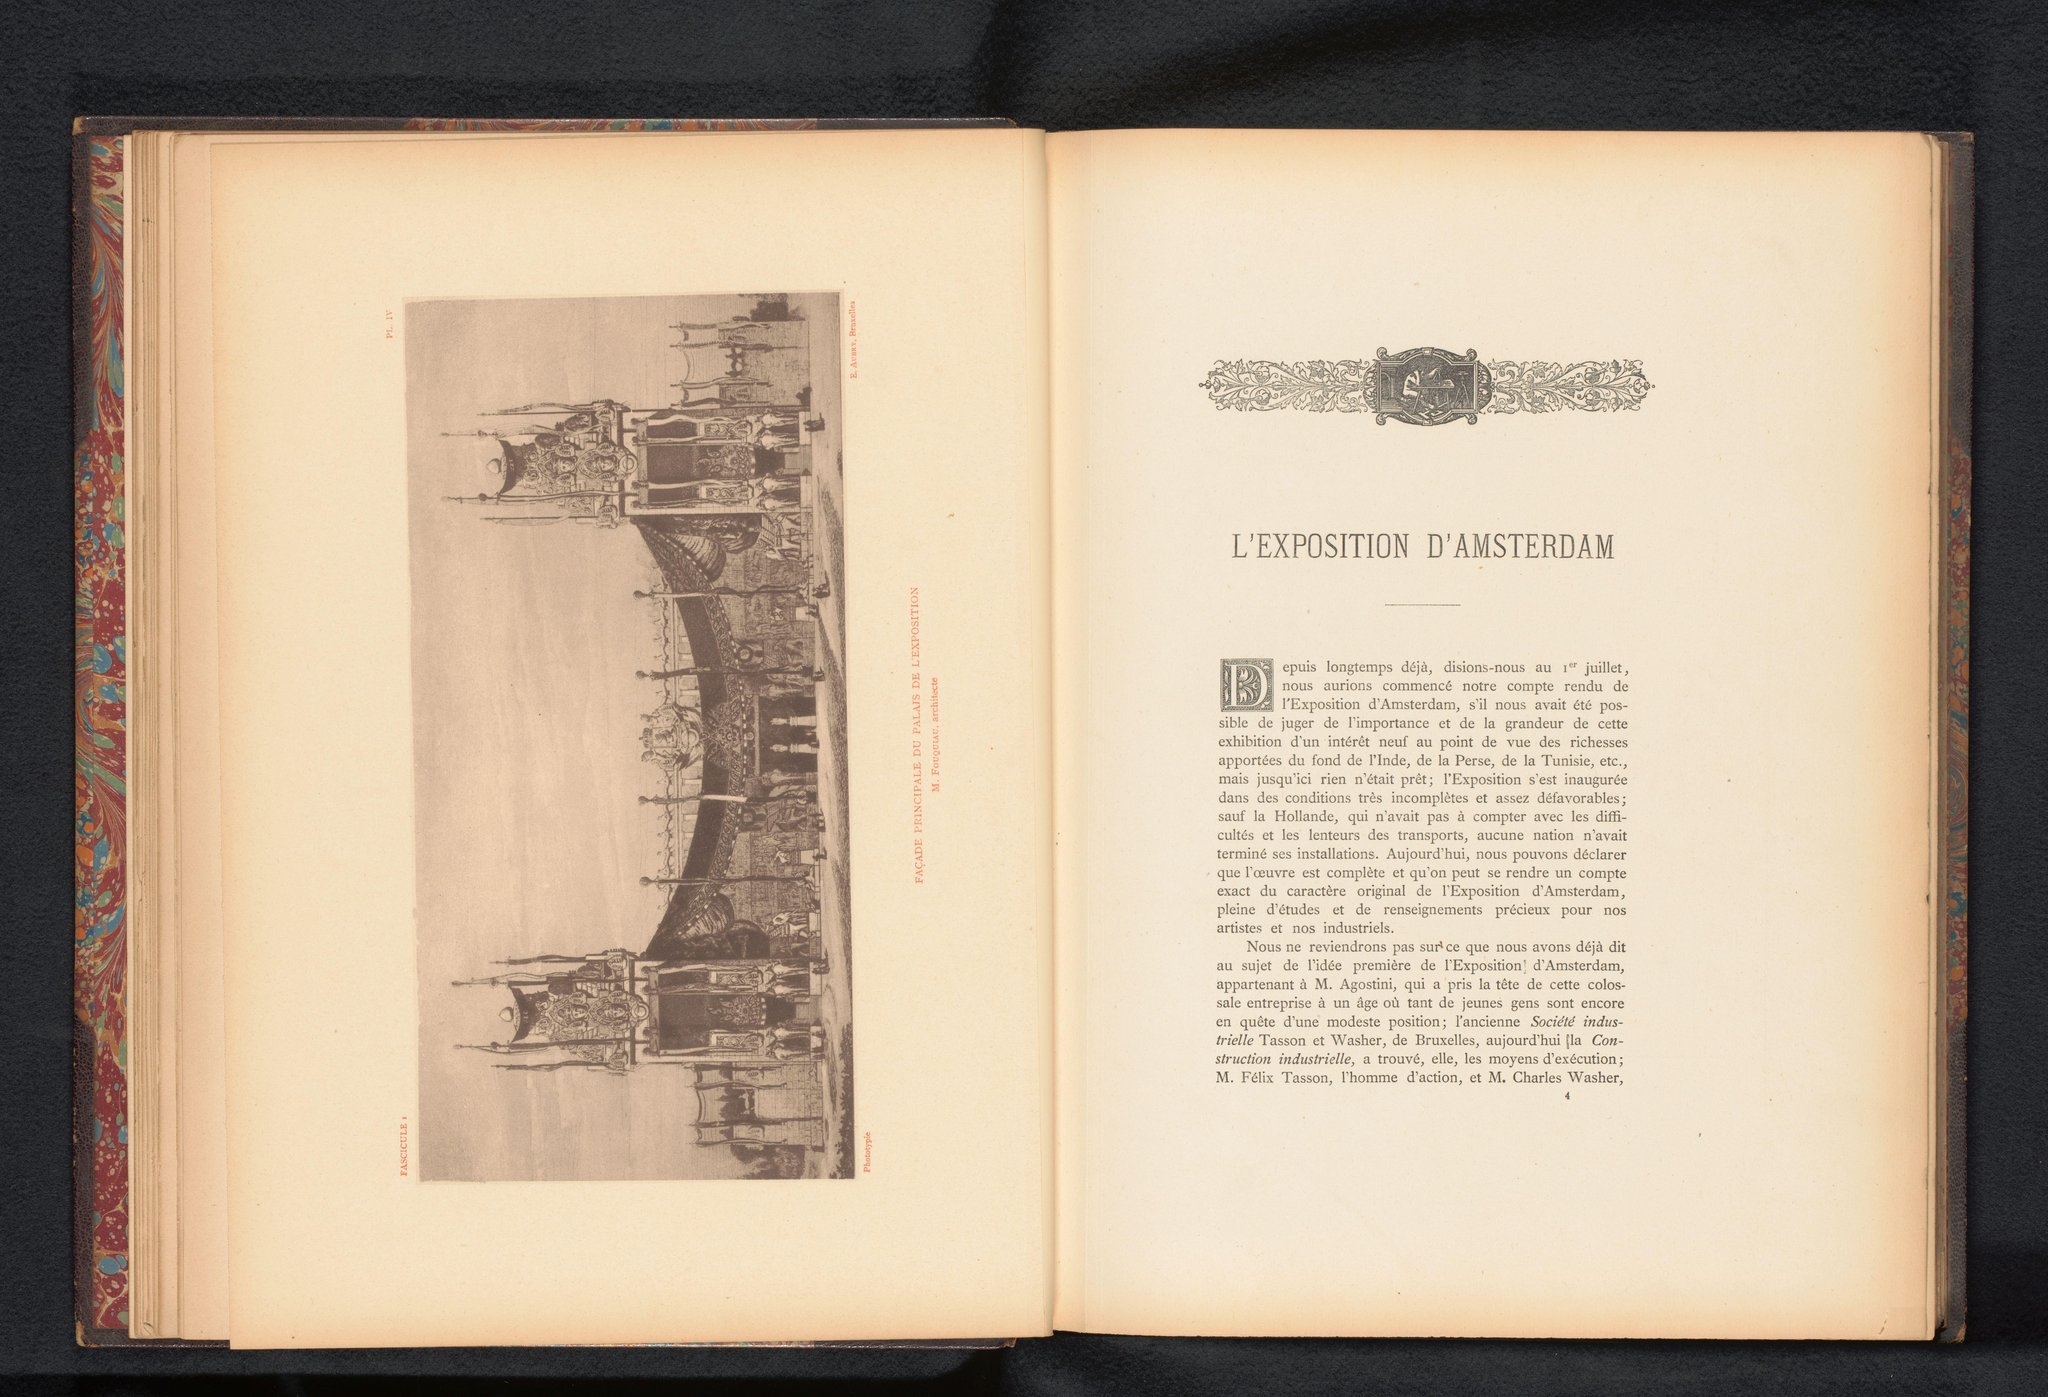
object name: reproduction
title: Façade principale du palais de l'exposition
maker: emile aubry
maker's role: print maker, printer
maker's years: 1829-1900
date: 1878-1883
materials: paper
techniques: photograph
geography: brussels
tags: world fair, world exhibition, palace, amsterdam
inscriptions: inscription: ‘M. Fouquiau, architecte’, inscription: ‘Fascicule I/ PL. IV’